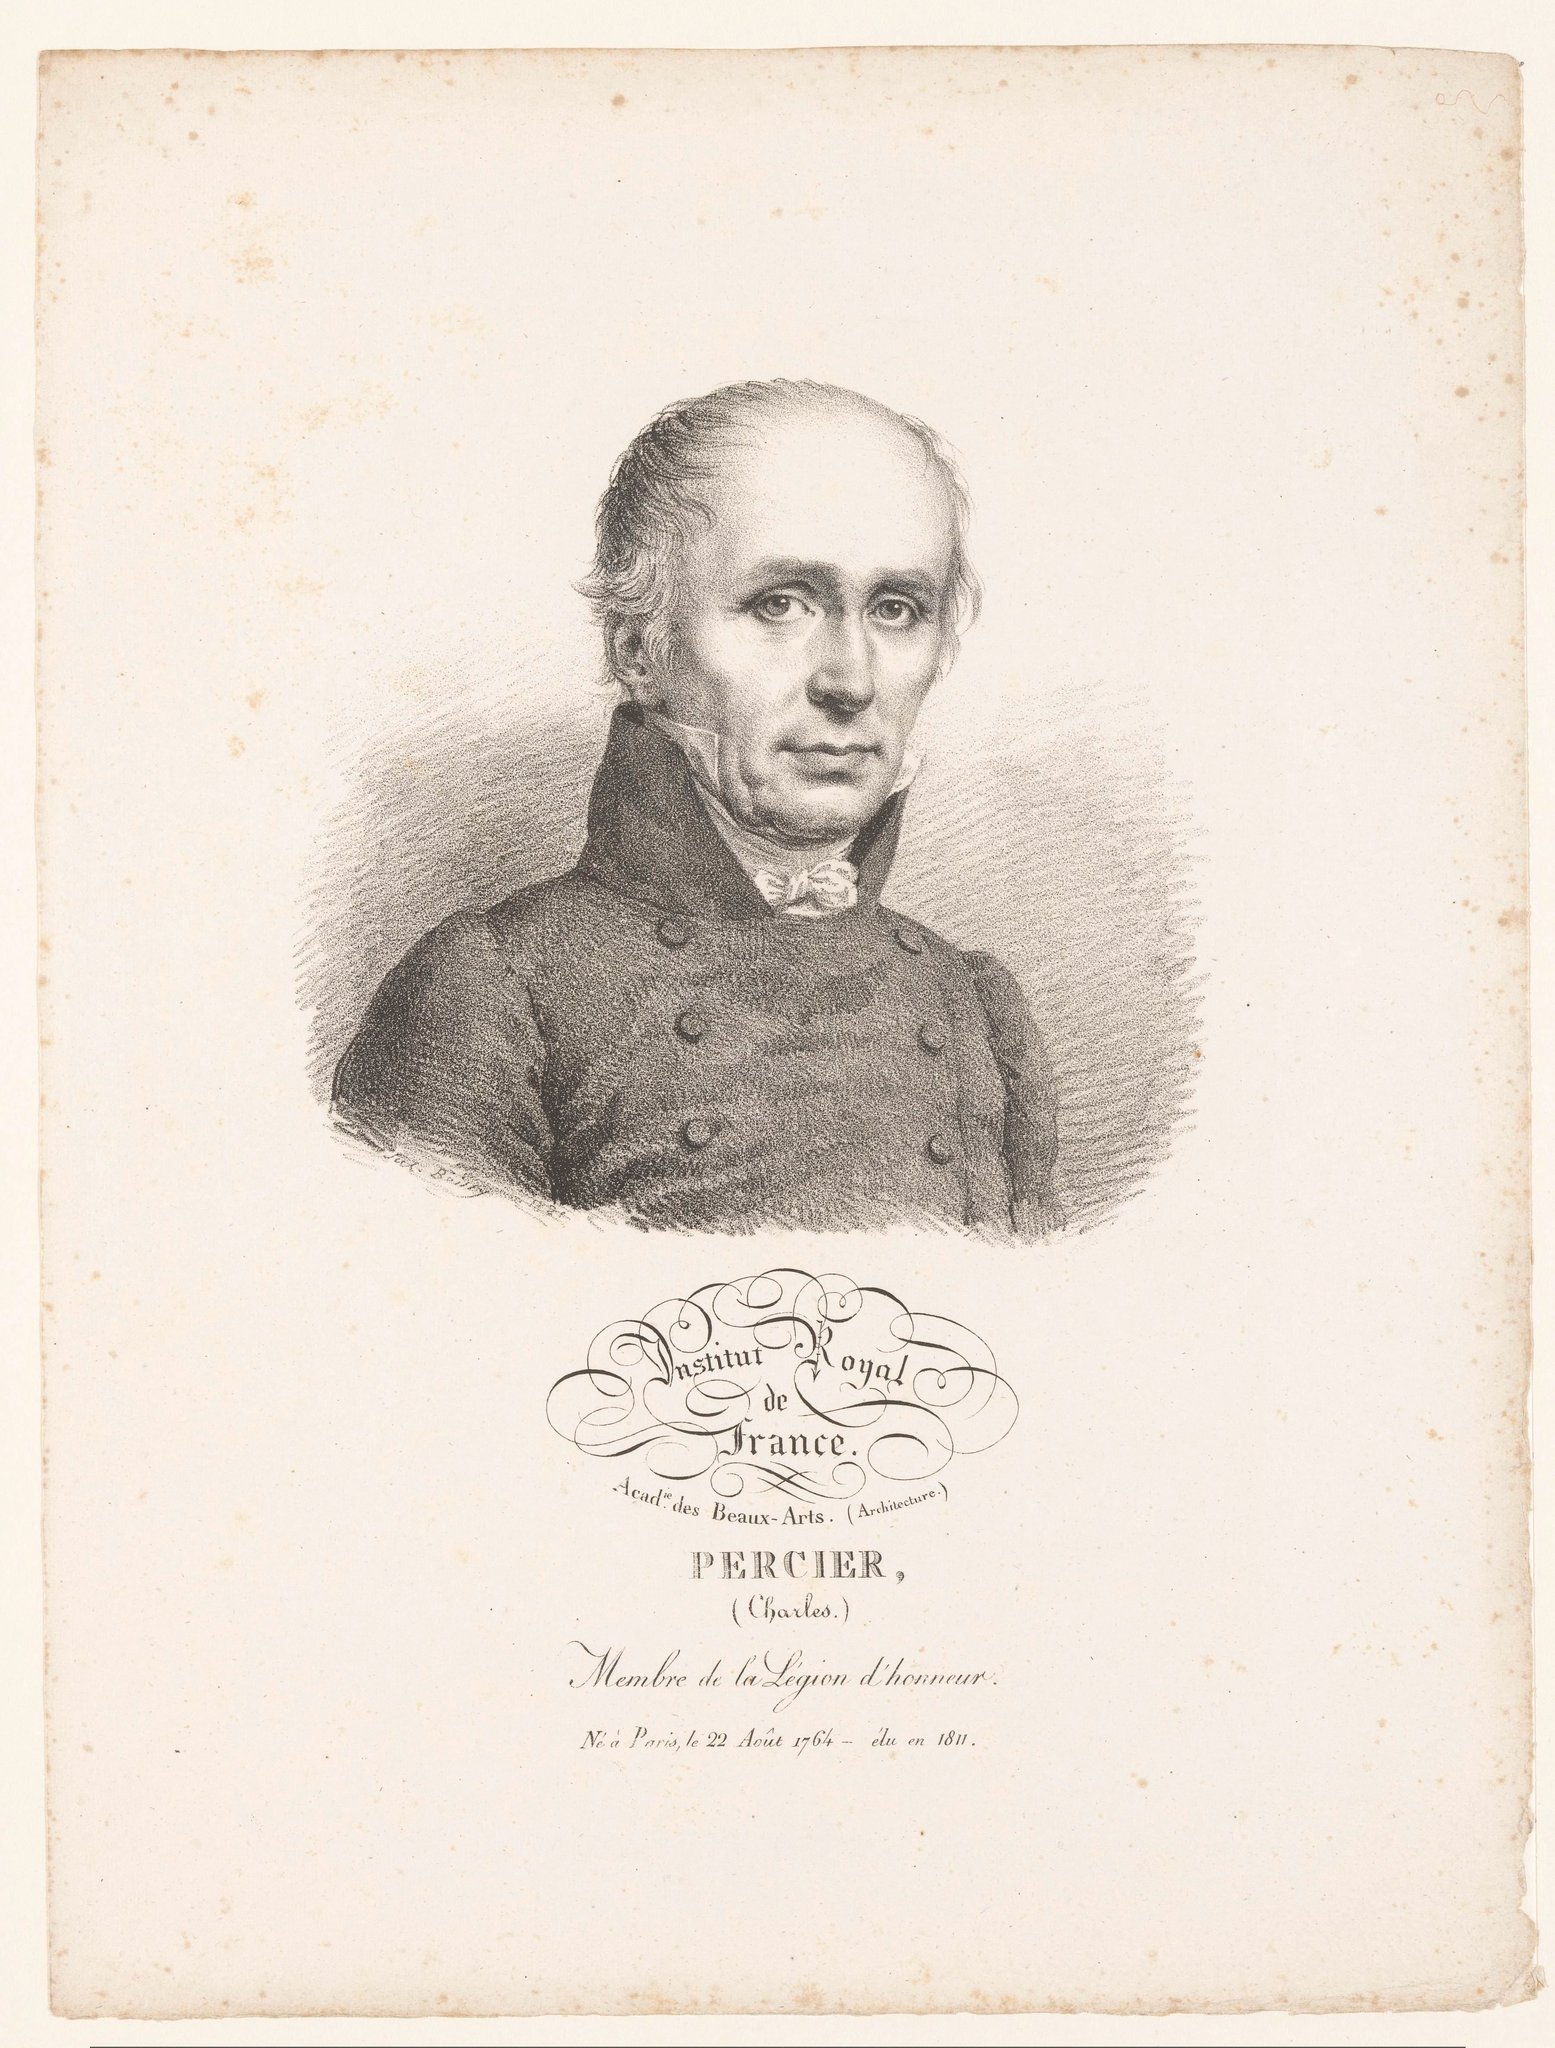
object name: print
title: Iconographie de l'Institut Royal de France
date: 1821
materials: paper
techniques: lithograph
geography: paris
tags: paris, designer, charles percier, historical persons, portrait, self-portrait of architect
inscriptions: collector's mark: Lugt 2228a